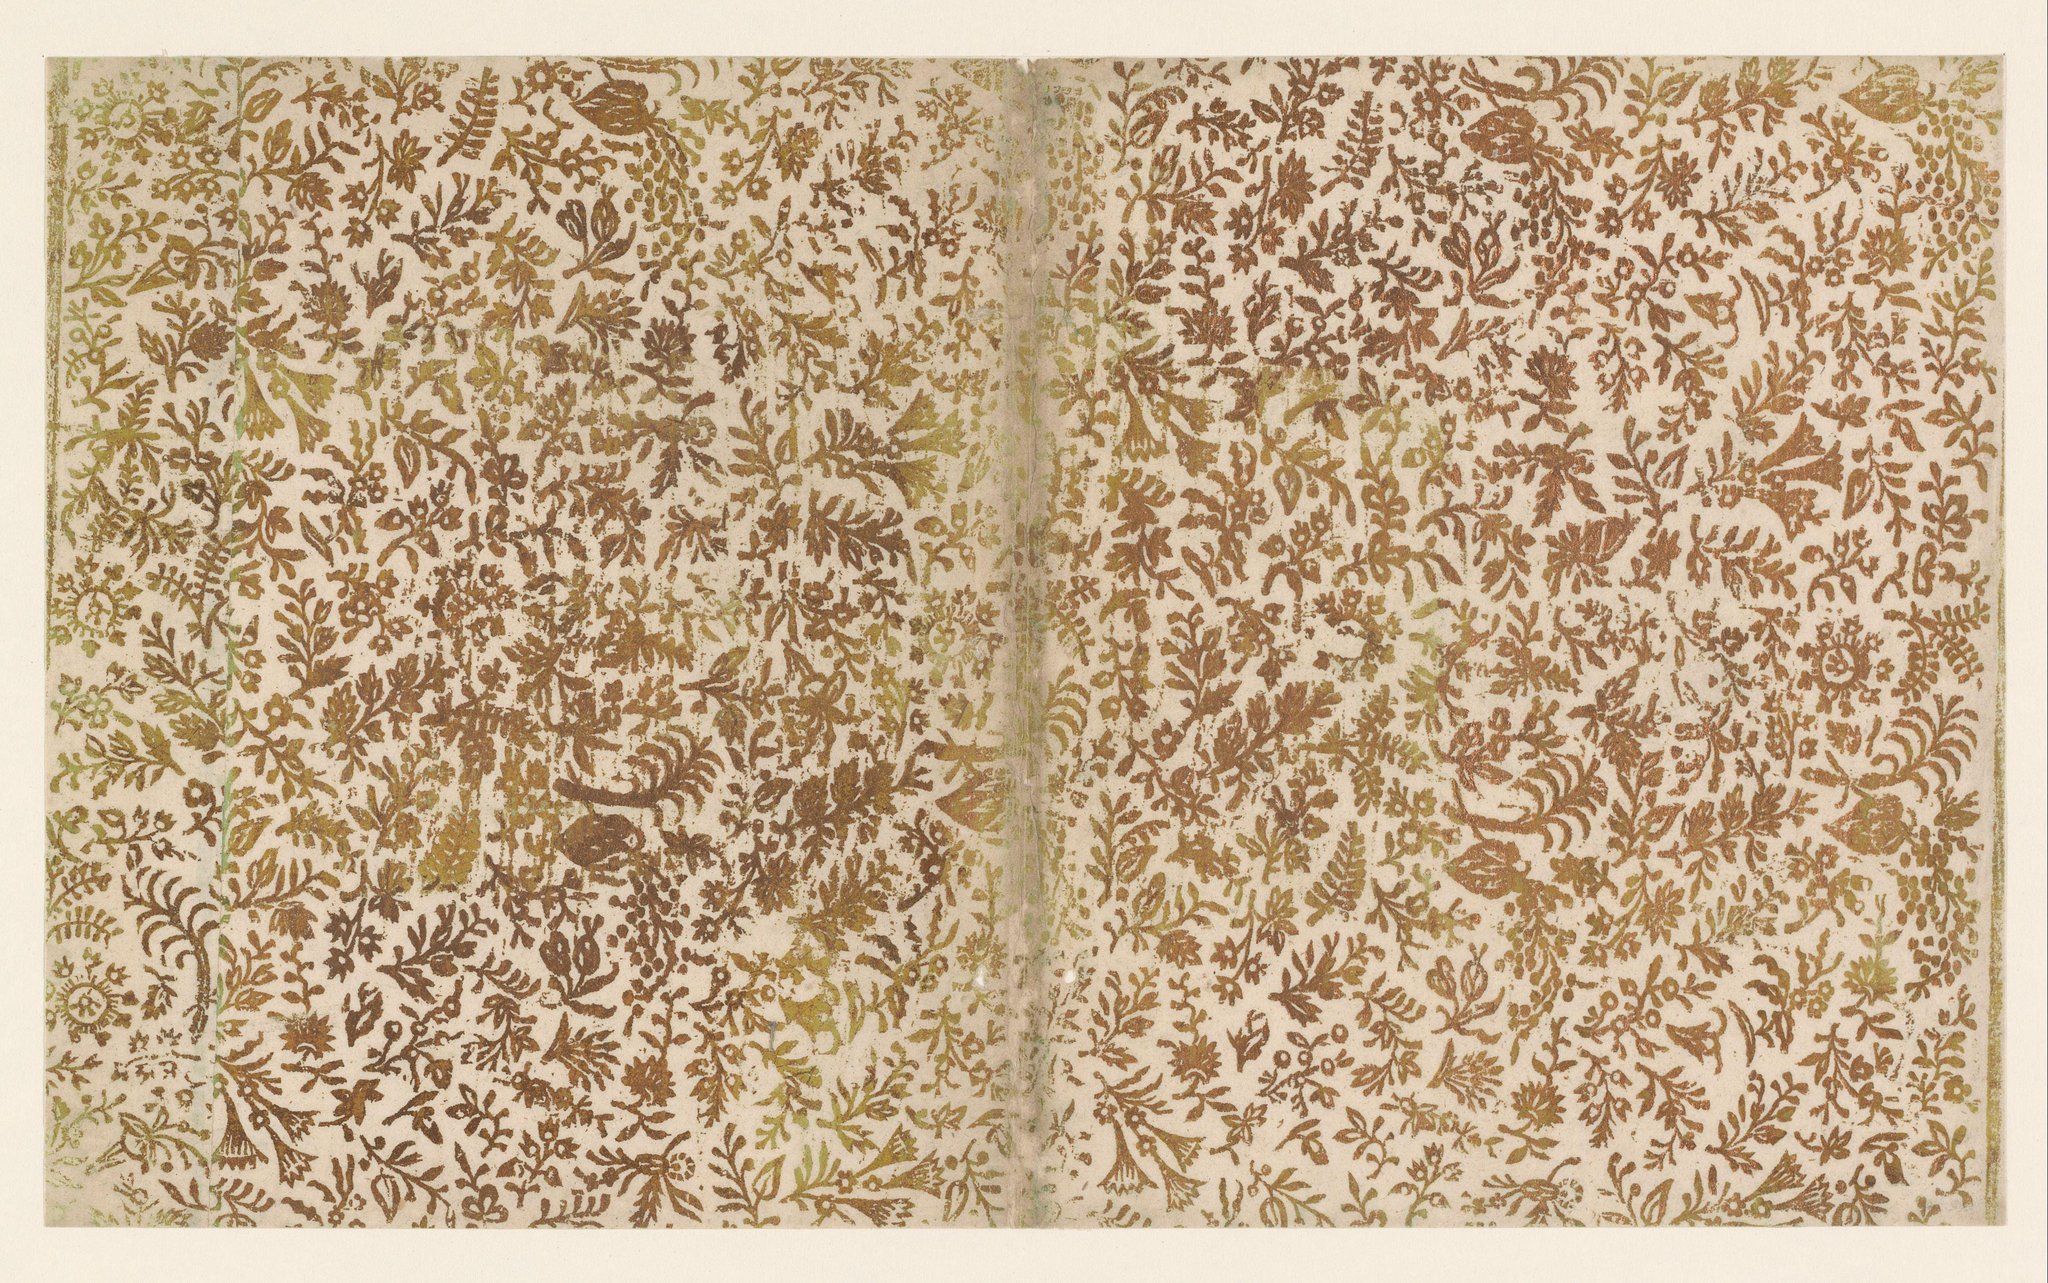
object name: brocade paper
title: Blad met strooipatroon van bladertakjes en bloemen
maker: Anonymous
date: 1700-1850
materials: gold leaf, paper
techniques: relief print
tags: ornament derived from plant forms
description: Blad met strooipatroon van bladertakjes en bloemen. Gebruikt als omslag.